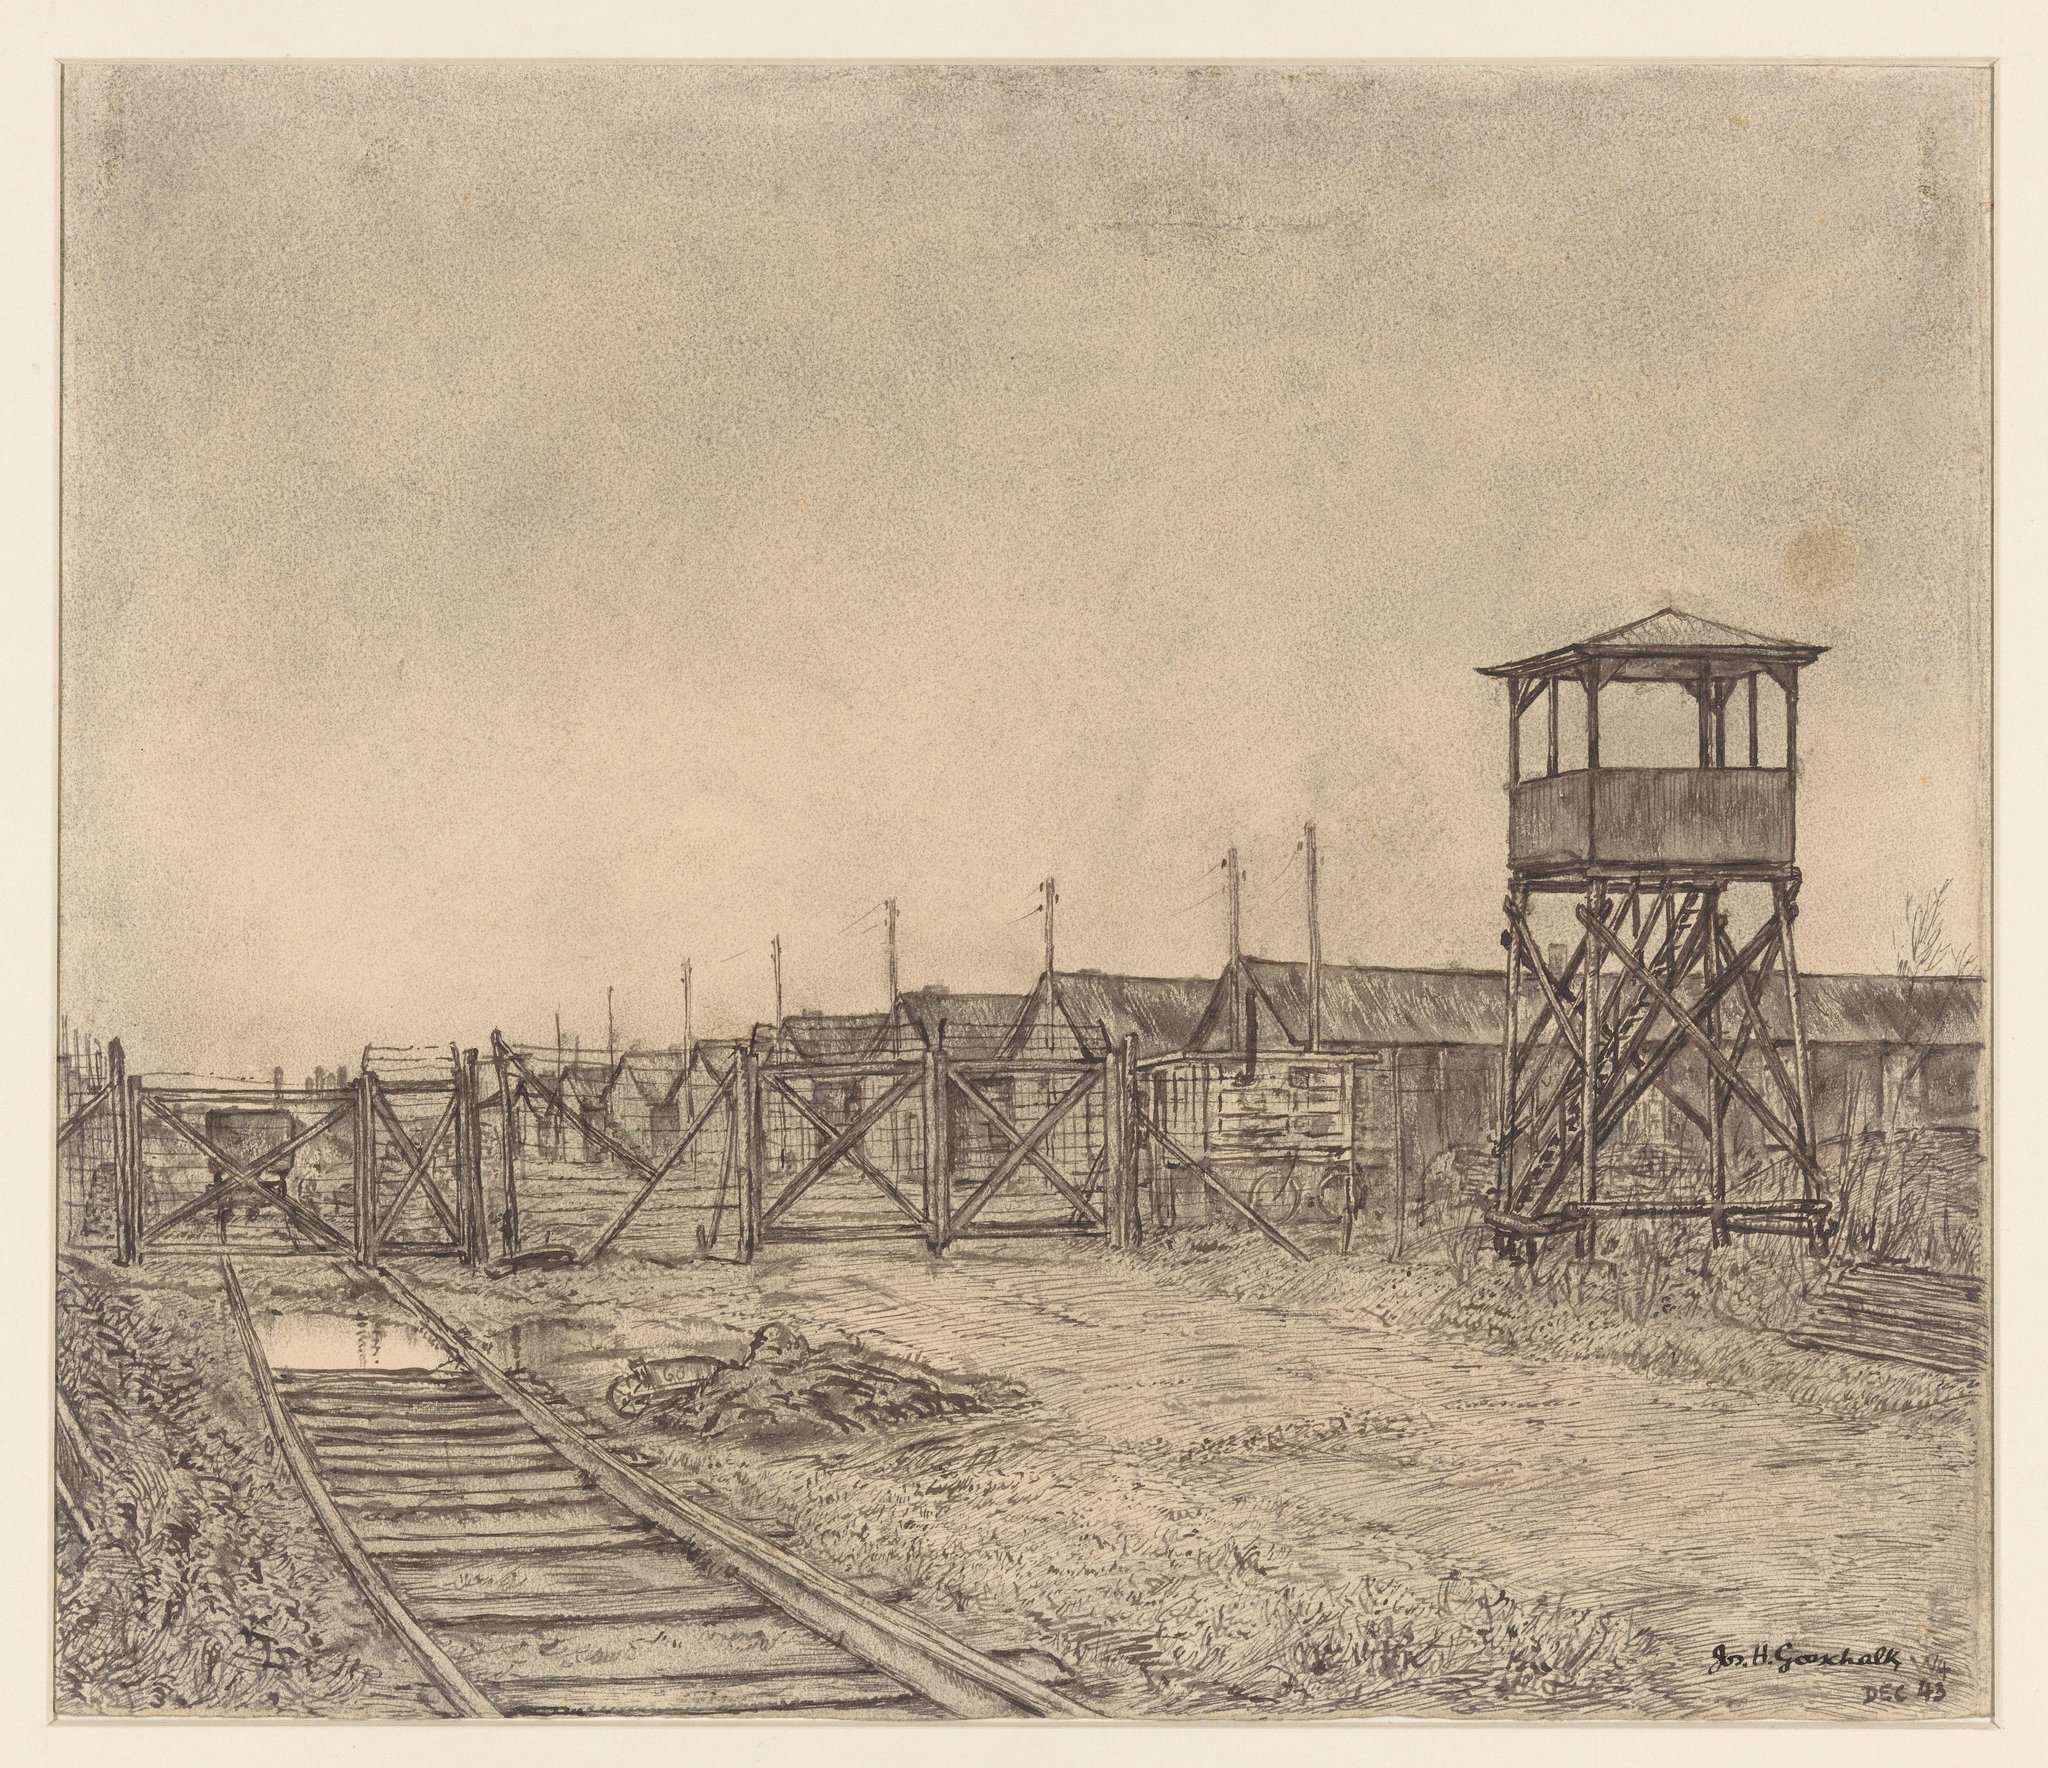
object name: drawing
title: Ingang van het kamp Westerbork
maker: joseph henry gosschalk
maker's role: draughtsman, print maker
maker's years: 1875-1952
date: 1912-1943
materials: chalk, ink, paper, pencil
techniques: brush, pen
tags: concentration camp, historical events and situations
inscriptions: annotation: ‘Gereprod in "Phoenix"’, collector's mark: Lugt 2228, stamp: ‘Jos. H. Gosschalk kunstschilder/ Wassenaarscheslag 1B Wassenaar/ Tel. 3052 - Postgiro 207454’